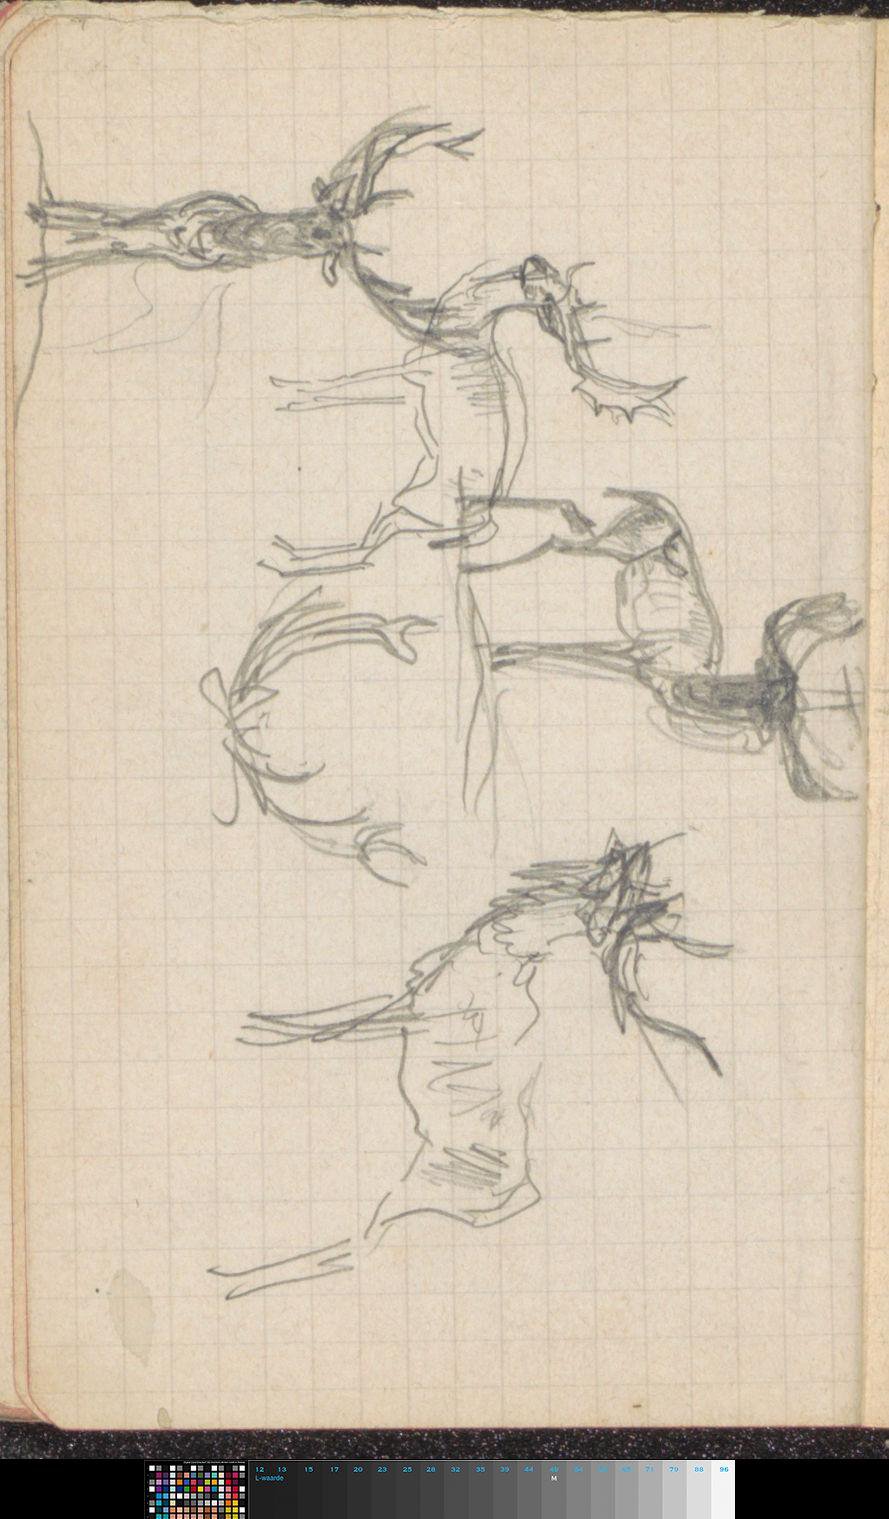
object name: sketchbook leaf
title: Herten, uit verschillende aanzichten gezien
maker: marius bauer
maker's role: draughtsman, print maker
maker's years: 1867-1932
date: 1902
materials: pencil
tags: hoofed animals: deer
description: Tevens een studie van een gewei. Pagina 24 uit een schetsboek met 23 bladen.